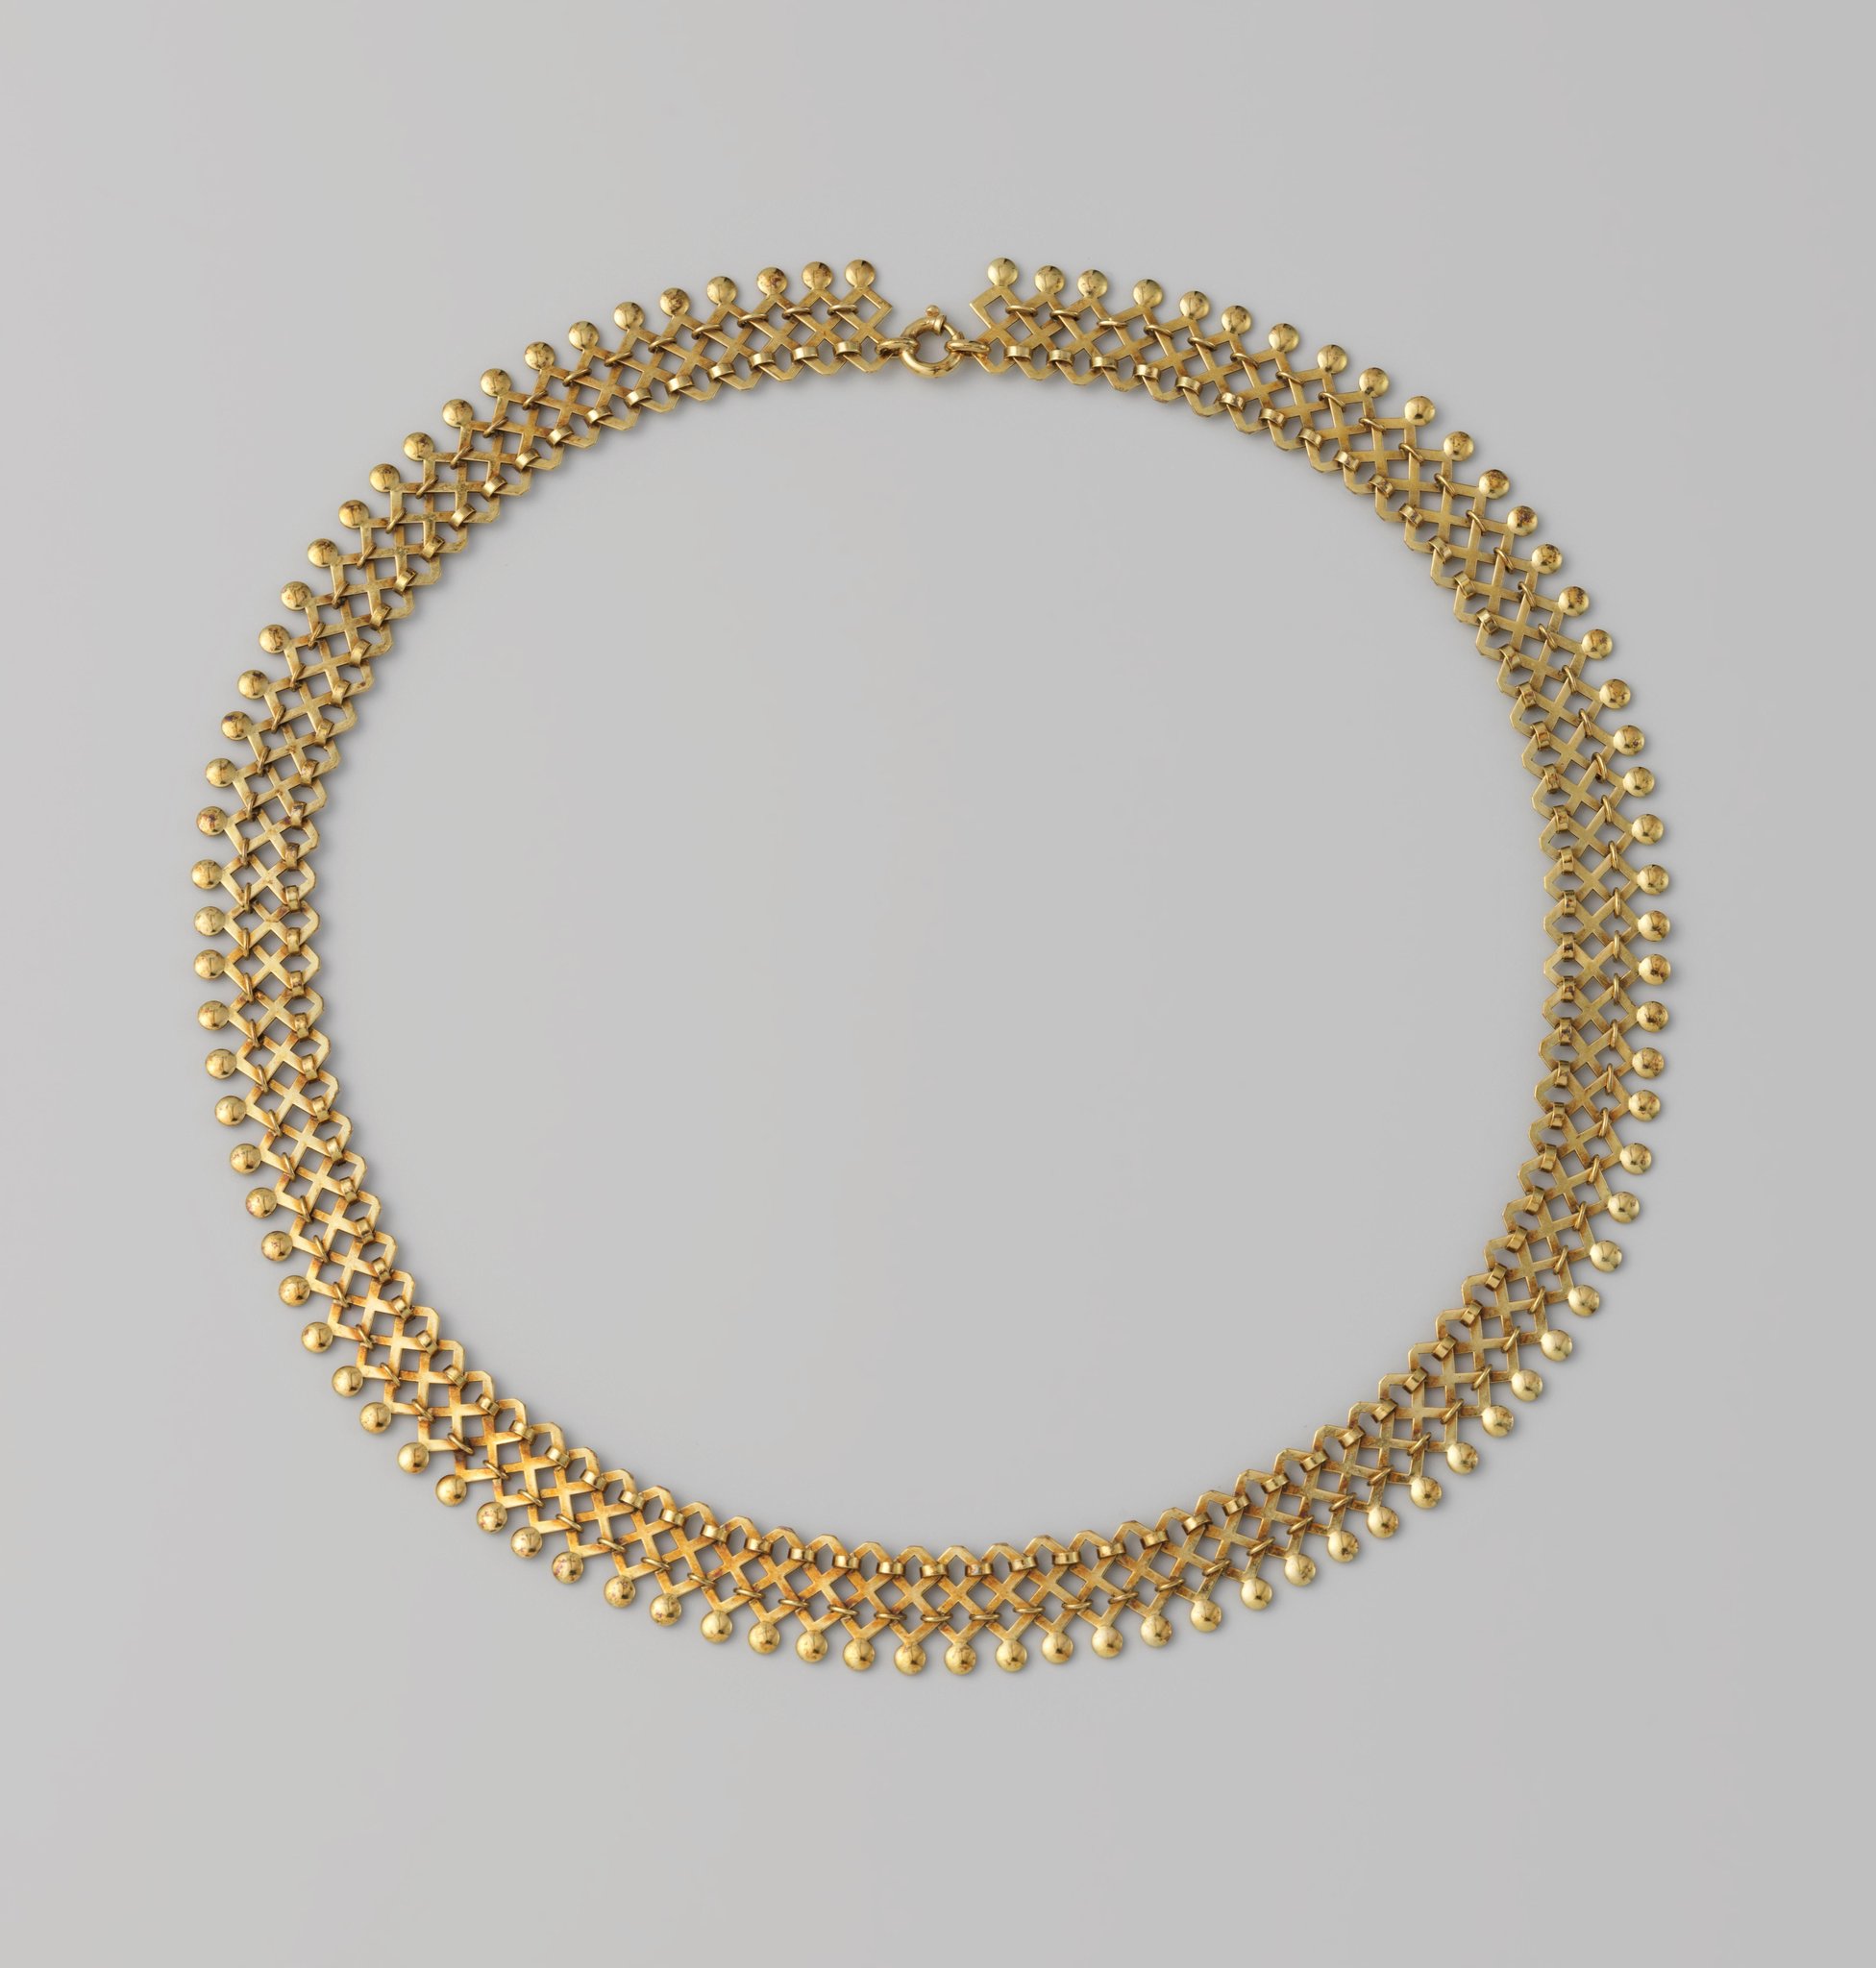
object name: necklace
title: Choker van goud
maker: Anonymous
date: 1954-1969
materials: gold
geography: germany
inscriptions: : ‘ovaal 585’, import mark: ‘SS+’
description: Choker van goud, bestaande uit geschakelde hoekige lemniscaten met aan de onderzijde een poli halve bol. De choker sluit met een veerring.